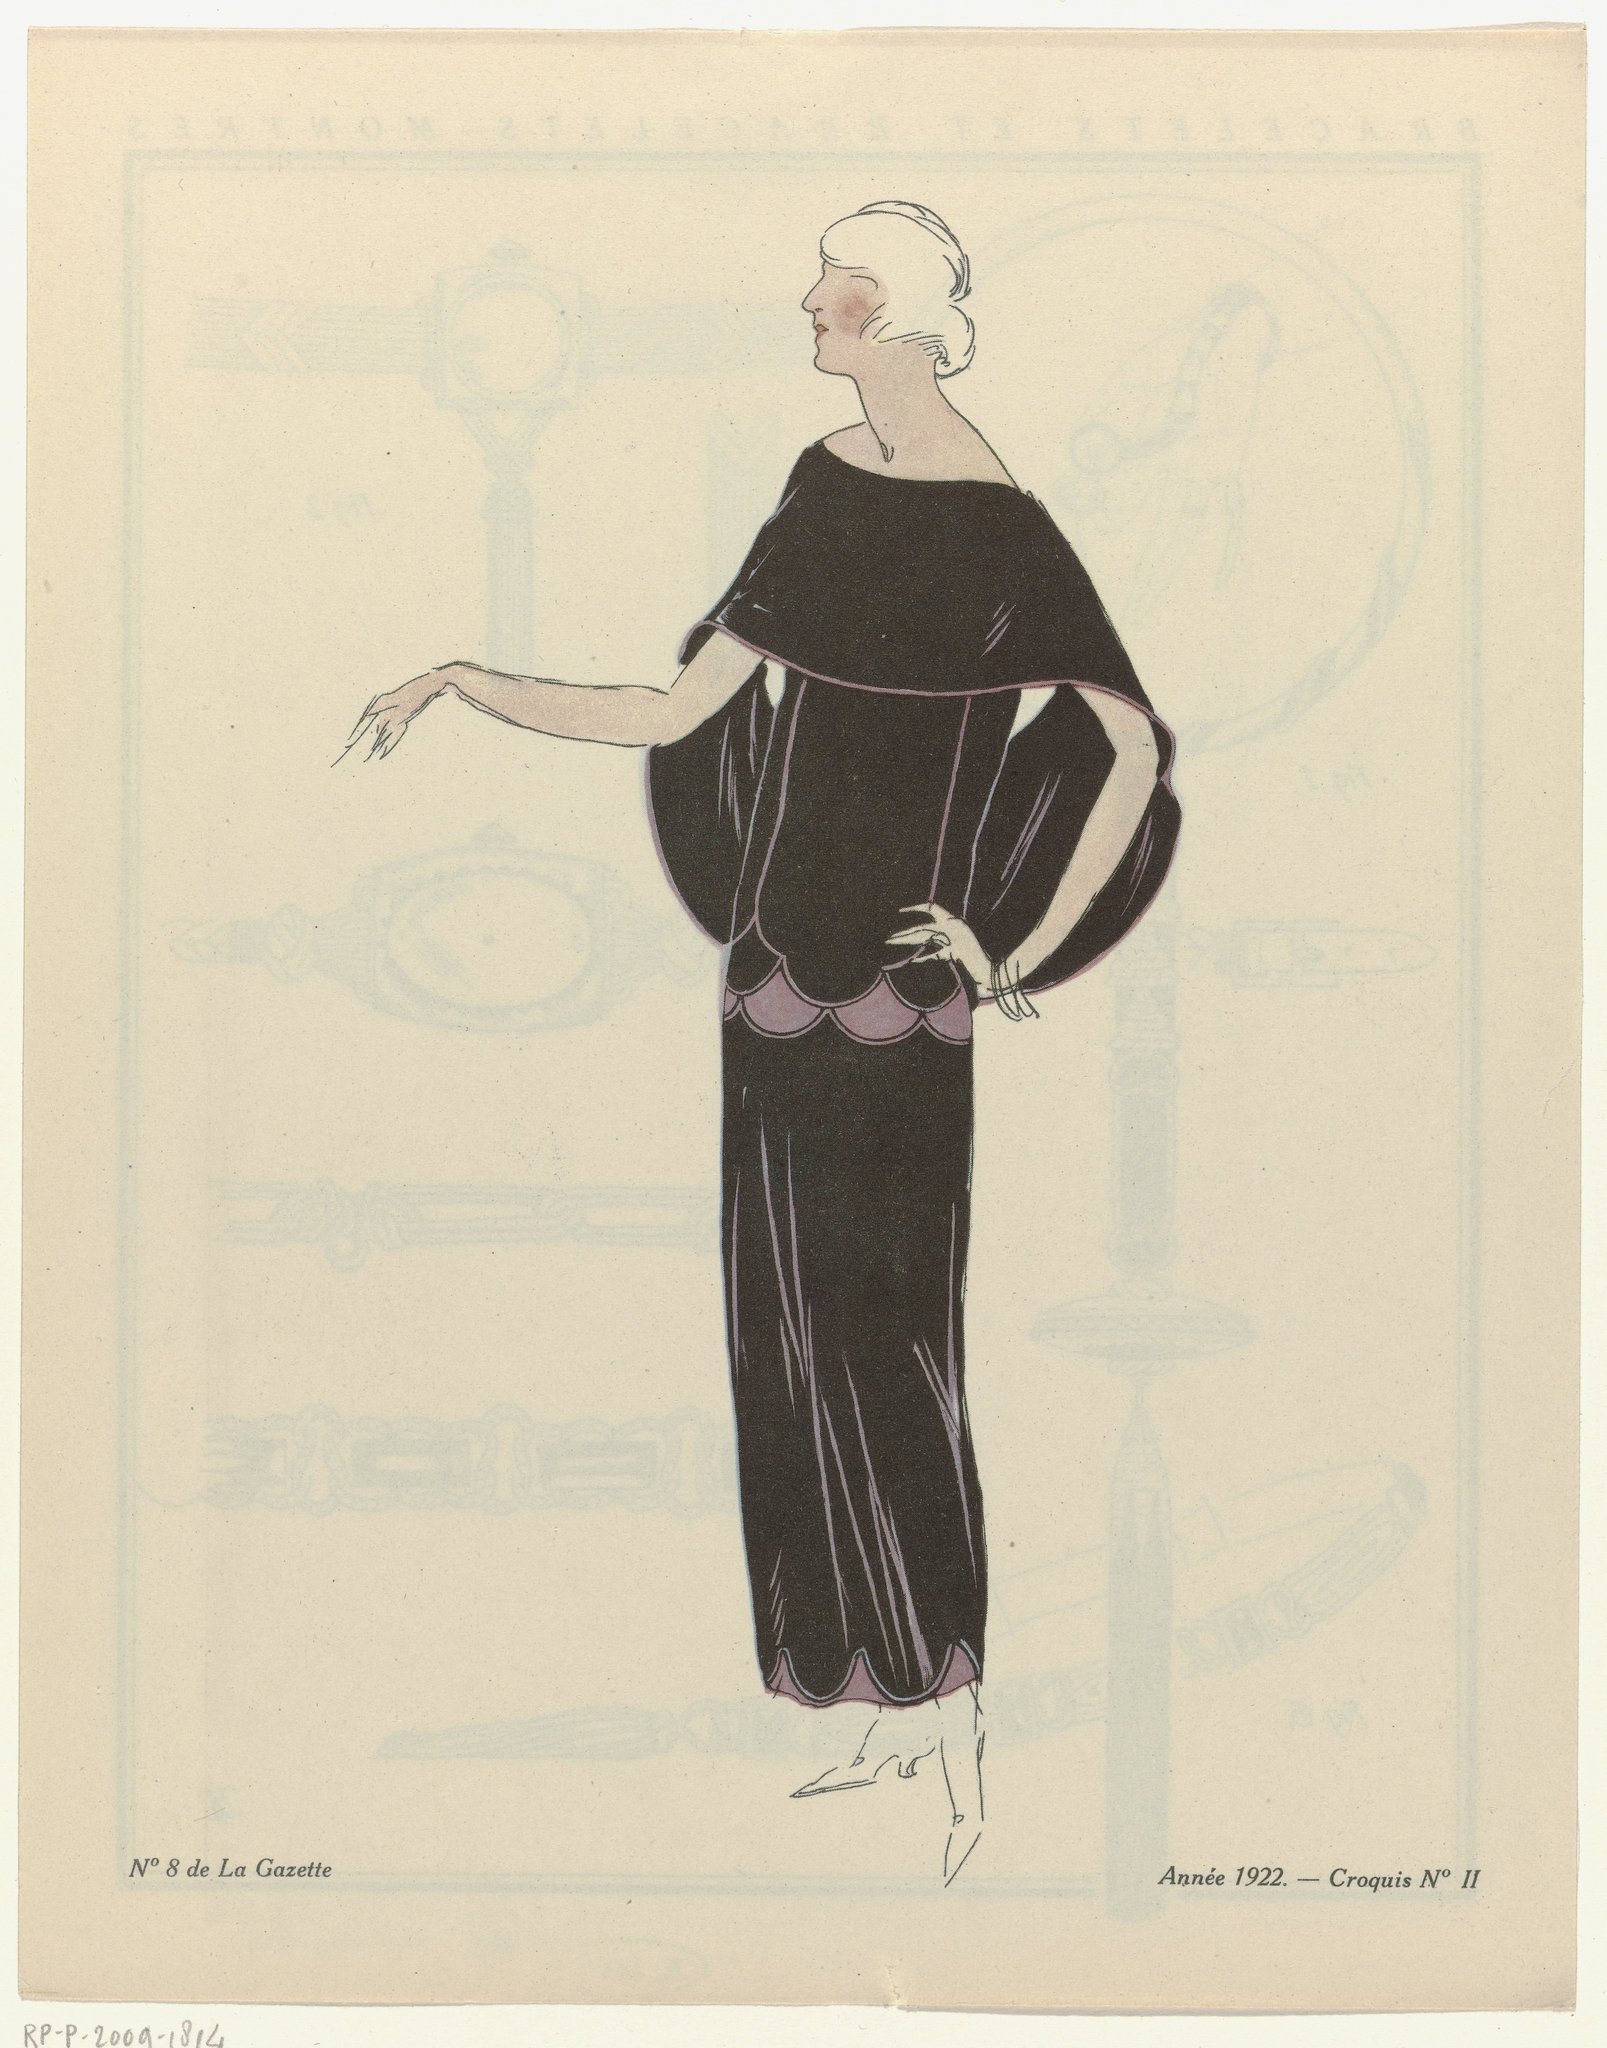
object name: fashion print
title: Gazette du Bon Ton, 1922, No. 8, Pl. II:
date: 1922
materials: paper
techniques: printing, letterpress printing, photochemical processes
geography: paris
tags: neck-gear: collar (+ women's clothes), fashion plates, dress, gown (+ women's clothes), watch, bracelet, wristlet (+ women's clothes)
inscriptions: title: ‘BRACELETS ET BRACELETS -MONTRES’, inscription: ‘No 8 de La Gazette / Année 1922. - Croquis No 11’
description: Japon met een wijde afhangende kraag, bij de zoom en taille een geschulpt patroon. Croquis No II uit Gazette du Bon Ton 1922, No. 8. Uitleg over de kleding op pagina "Description et explication des planches hors-texte et pages de croquis." Verso : armbanden en polshorloges, genummerd 1 t/m 6.